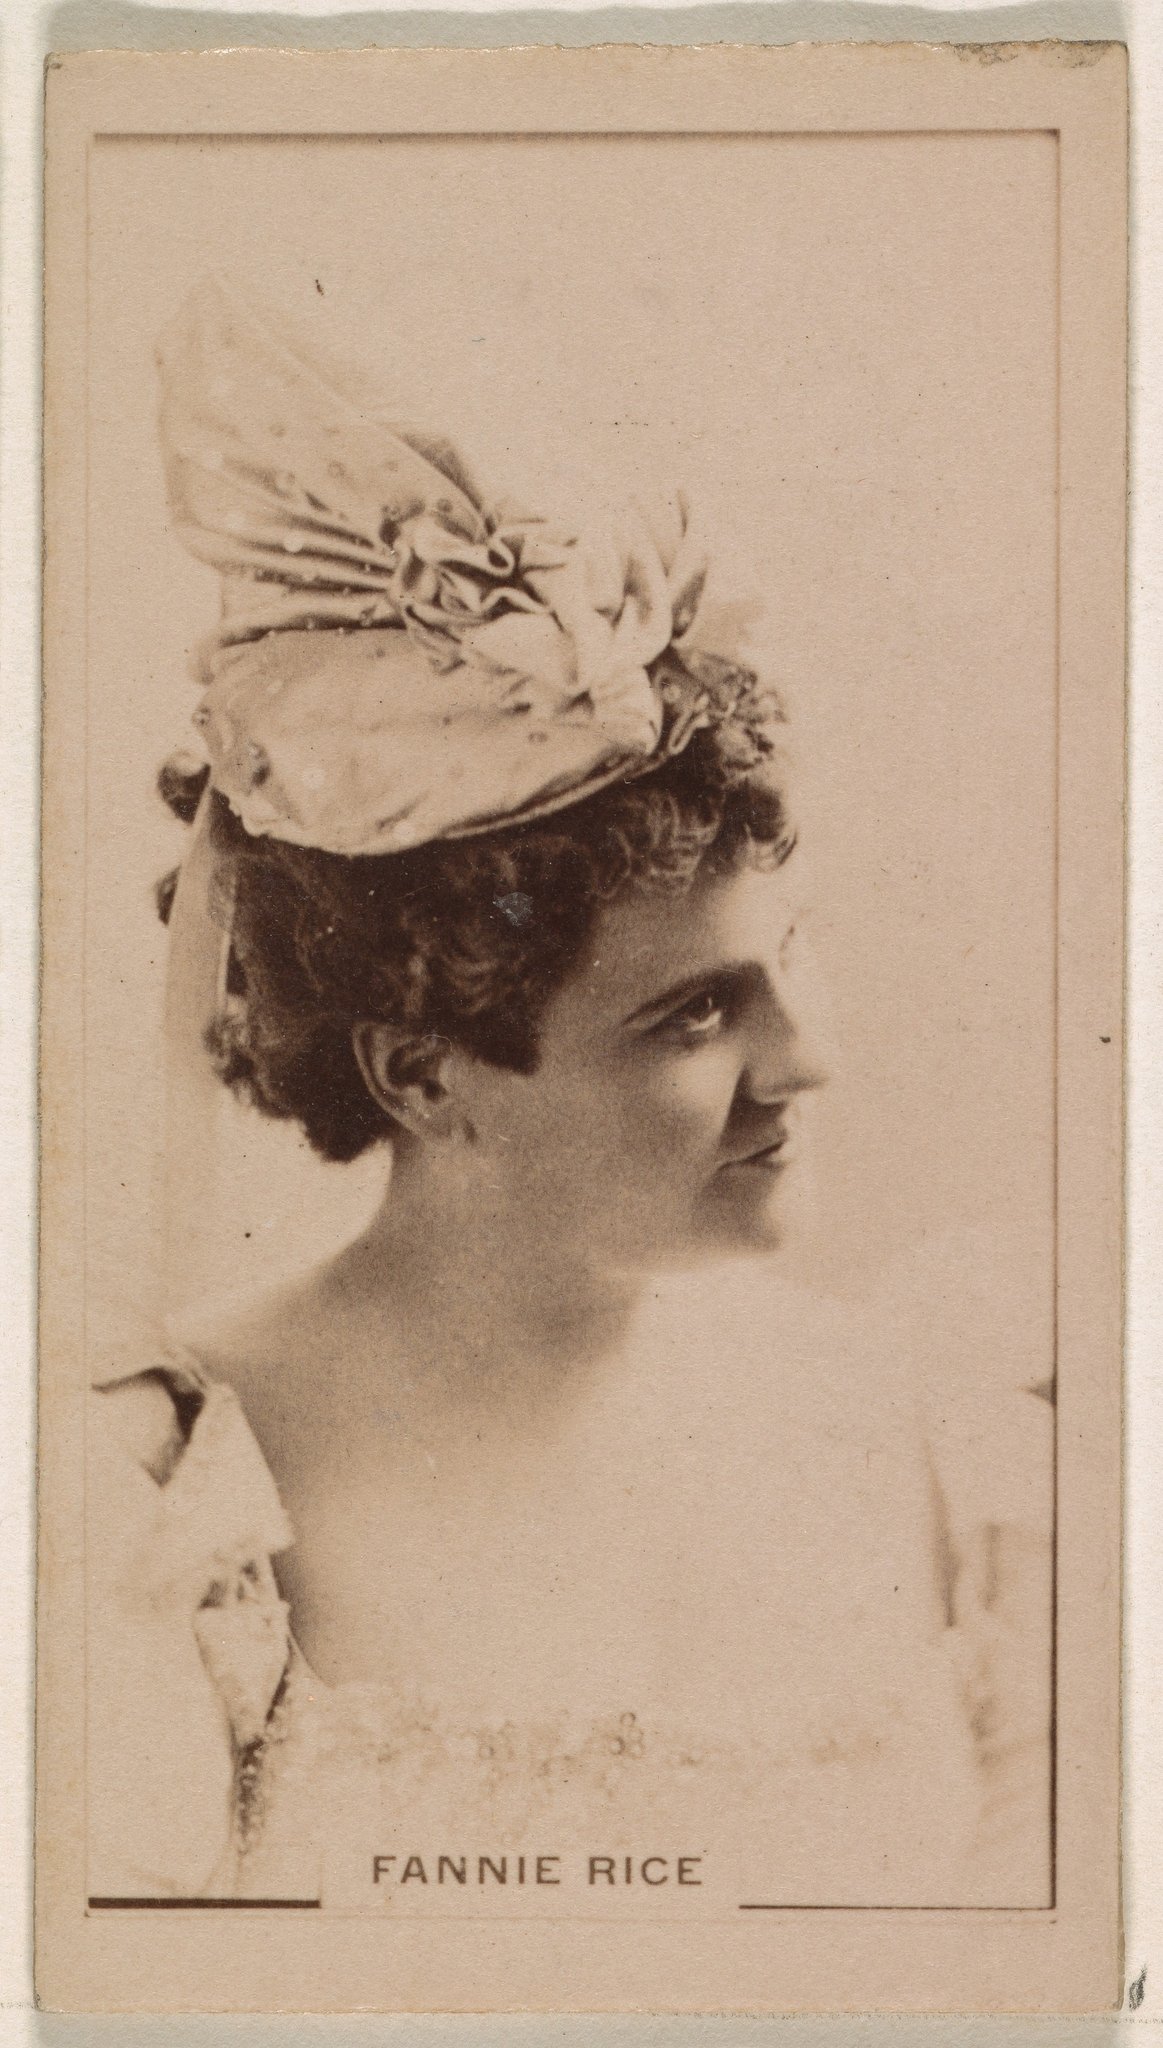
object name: photograph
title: Fannie Rice, from the Actresses series (N245) issued by Kinney Brothers to promote Sweet Caporal Cigarettes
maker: kinney brothers tobacco company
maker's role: publisher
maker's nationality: american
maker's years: 1869-2011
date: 1890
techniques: albumen silver print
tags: women,actresses